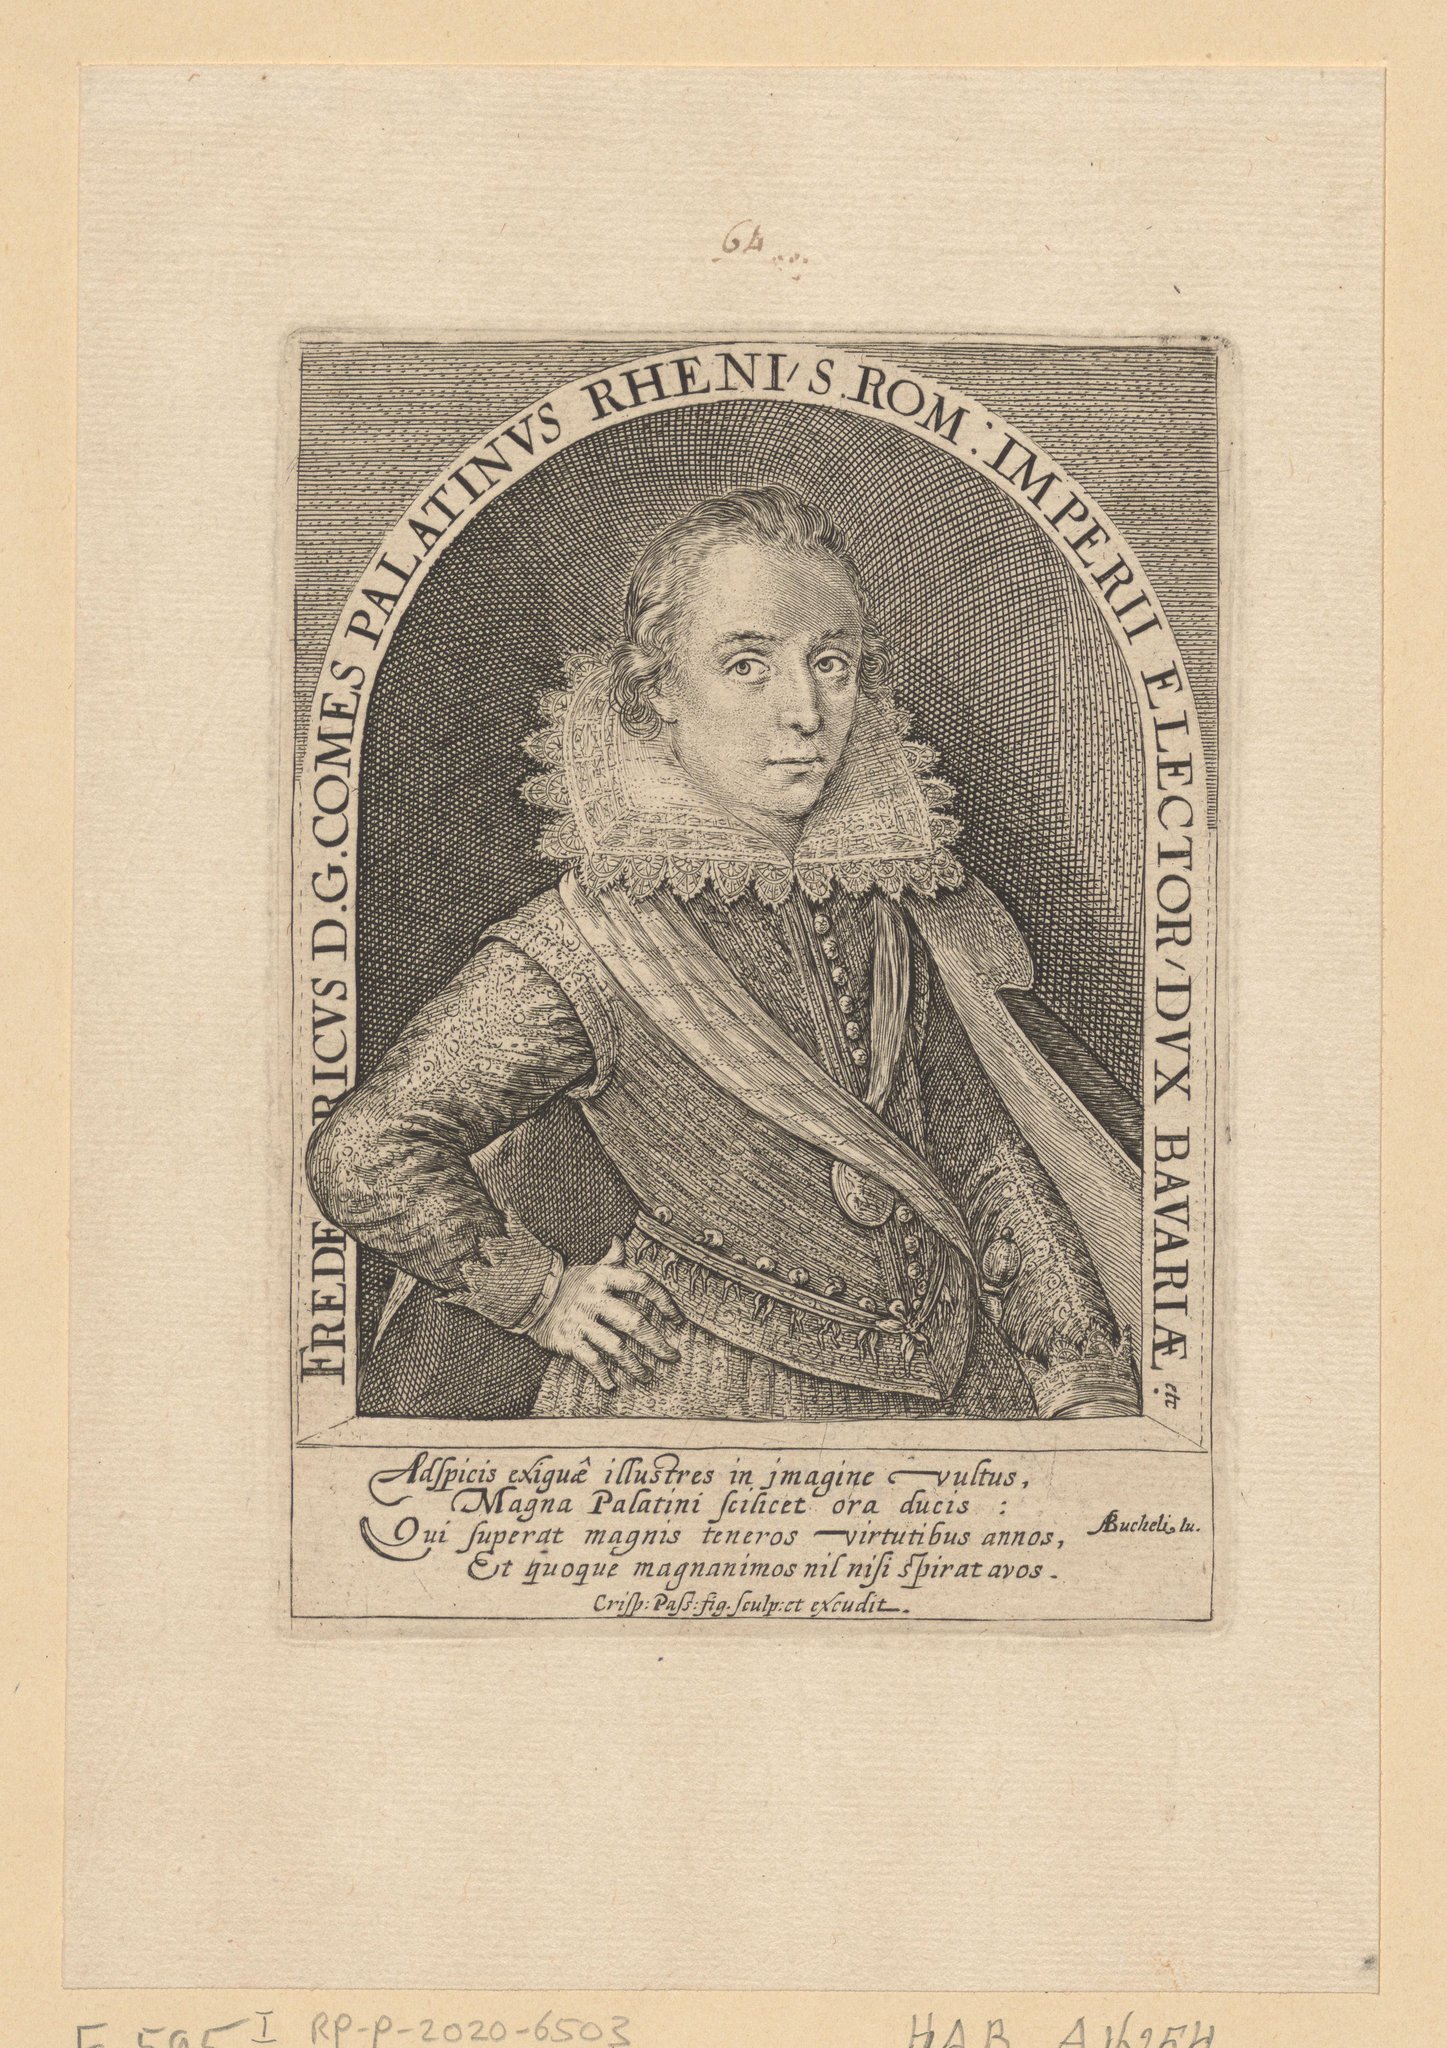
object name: print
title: Portret van Frederik V van de Palts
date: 1613-1637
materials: paper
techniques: engraving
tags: amberg, frederik v (keurvorst van de palts, koning van bohemen), historical persons, ruler, sovereign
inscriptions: number: ‘64’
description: Met vierregelig vers in het Latijn onder het portret.